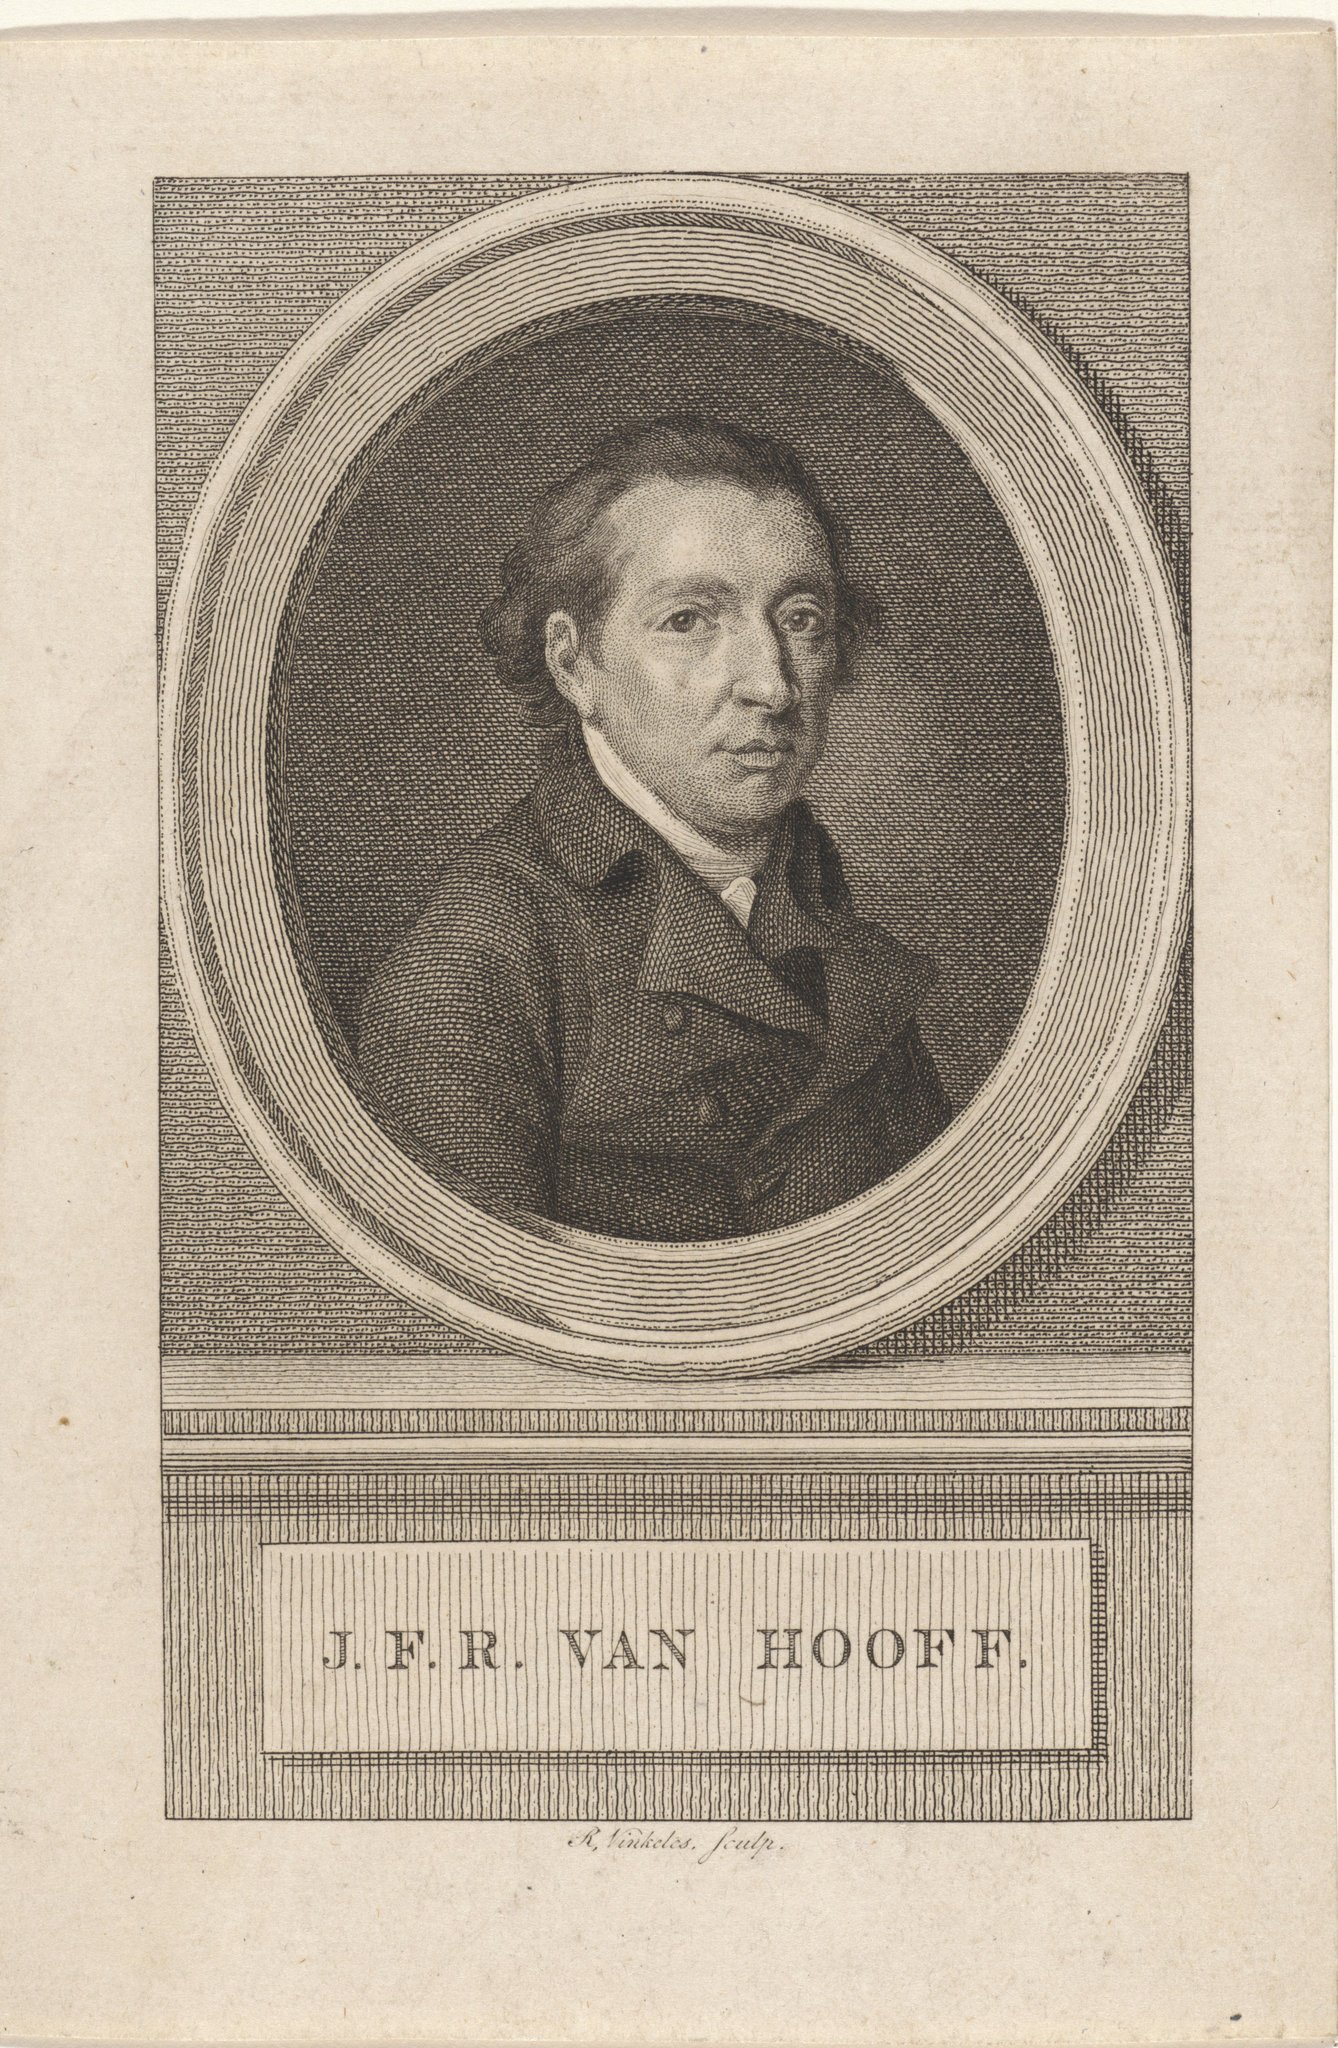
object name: print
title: Portret van Johan Frederik Rudolph van Hooff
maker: reinier vinkeles (i)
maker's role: draughtsman, print maker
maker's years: 1741-1816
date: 1786-1809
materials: paper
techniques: engraving, etching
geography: amsterdam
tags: johan frederik rudolph van hooff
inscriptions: collector's mark: Lugt 2228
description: Prent ook gebruikt als boekillustratie in: Wagenaar, Jan. Vaderlandsche historie, (...) ten vervolge van Wagenaars Vaderlandsche historie. Dl. 1-43. Amsterdam: Johannes Allart, 1786-1809.